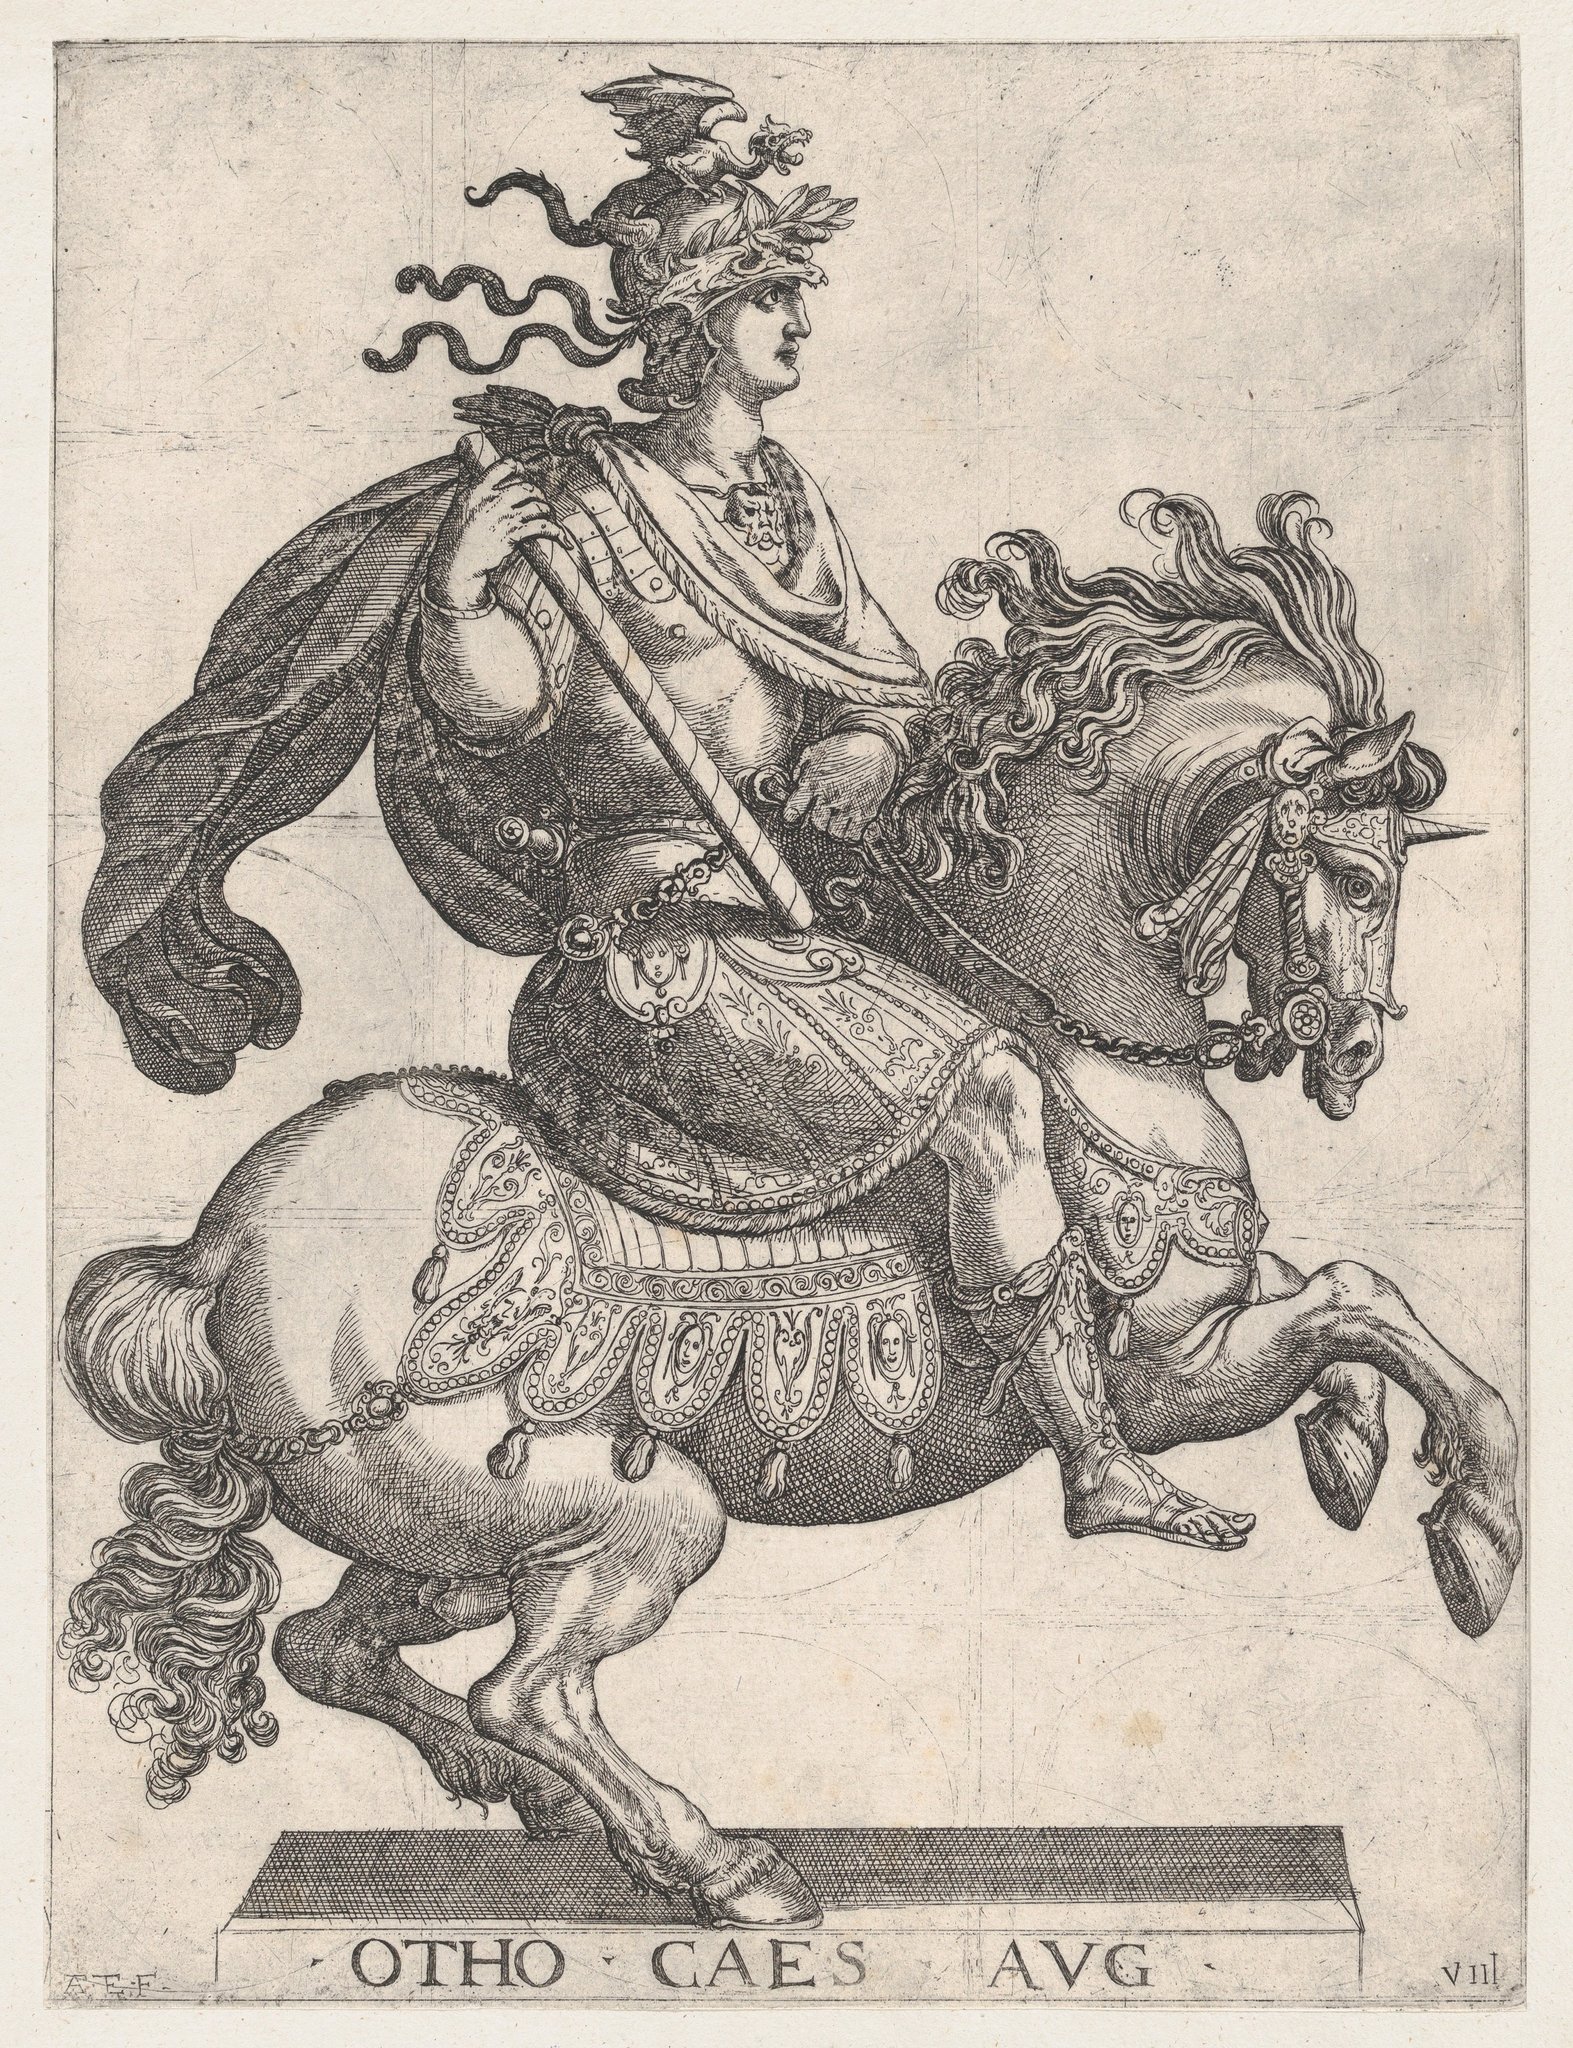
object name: print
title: Plate 8: Emperor Otho on Horseback, from 'The First Twelve Roman Caesars'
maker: antonio tempesta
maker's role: artist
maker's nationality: italian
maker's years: 1555-1630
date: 1596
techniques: etching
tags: men,horses